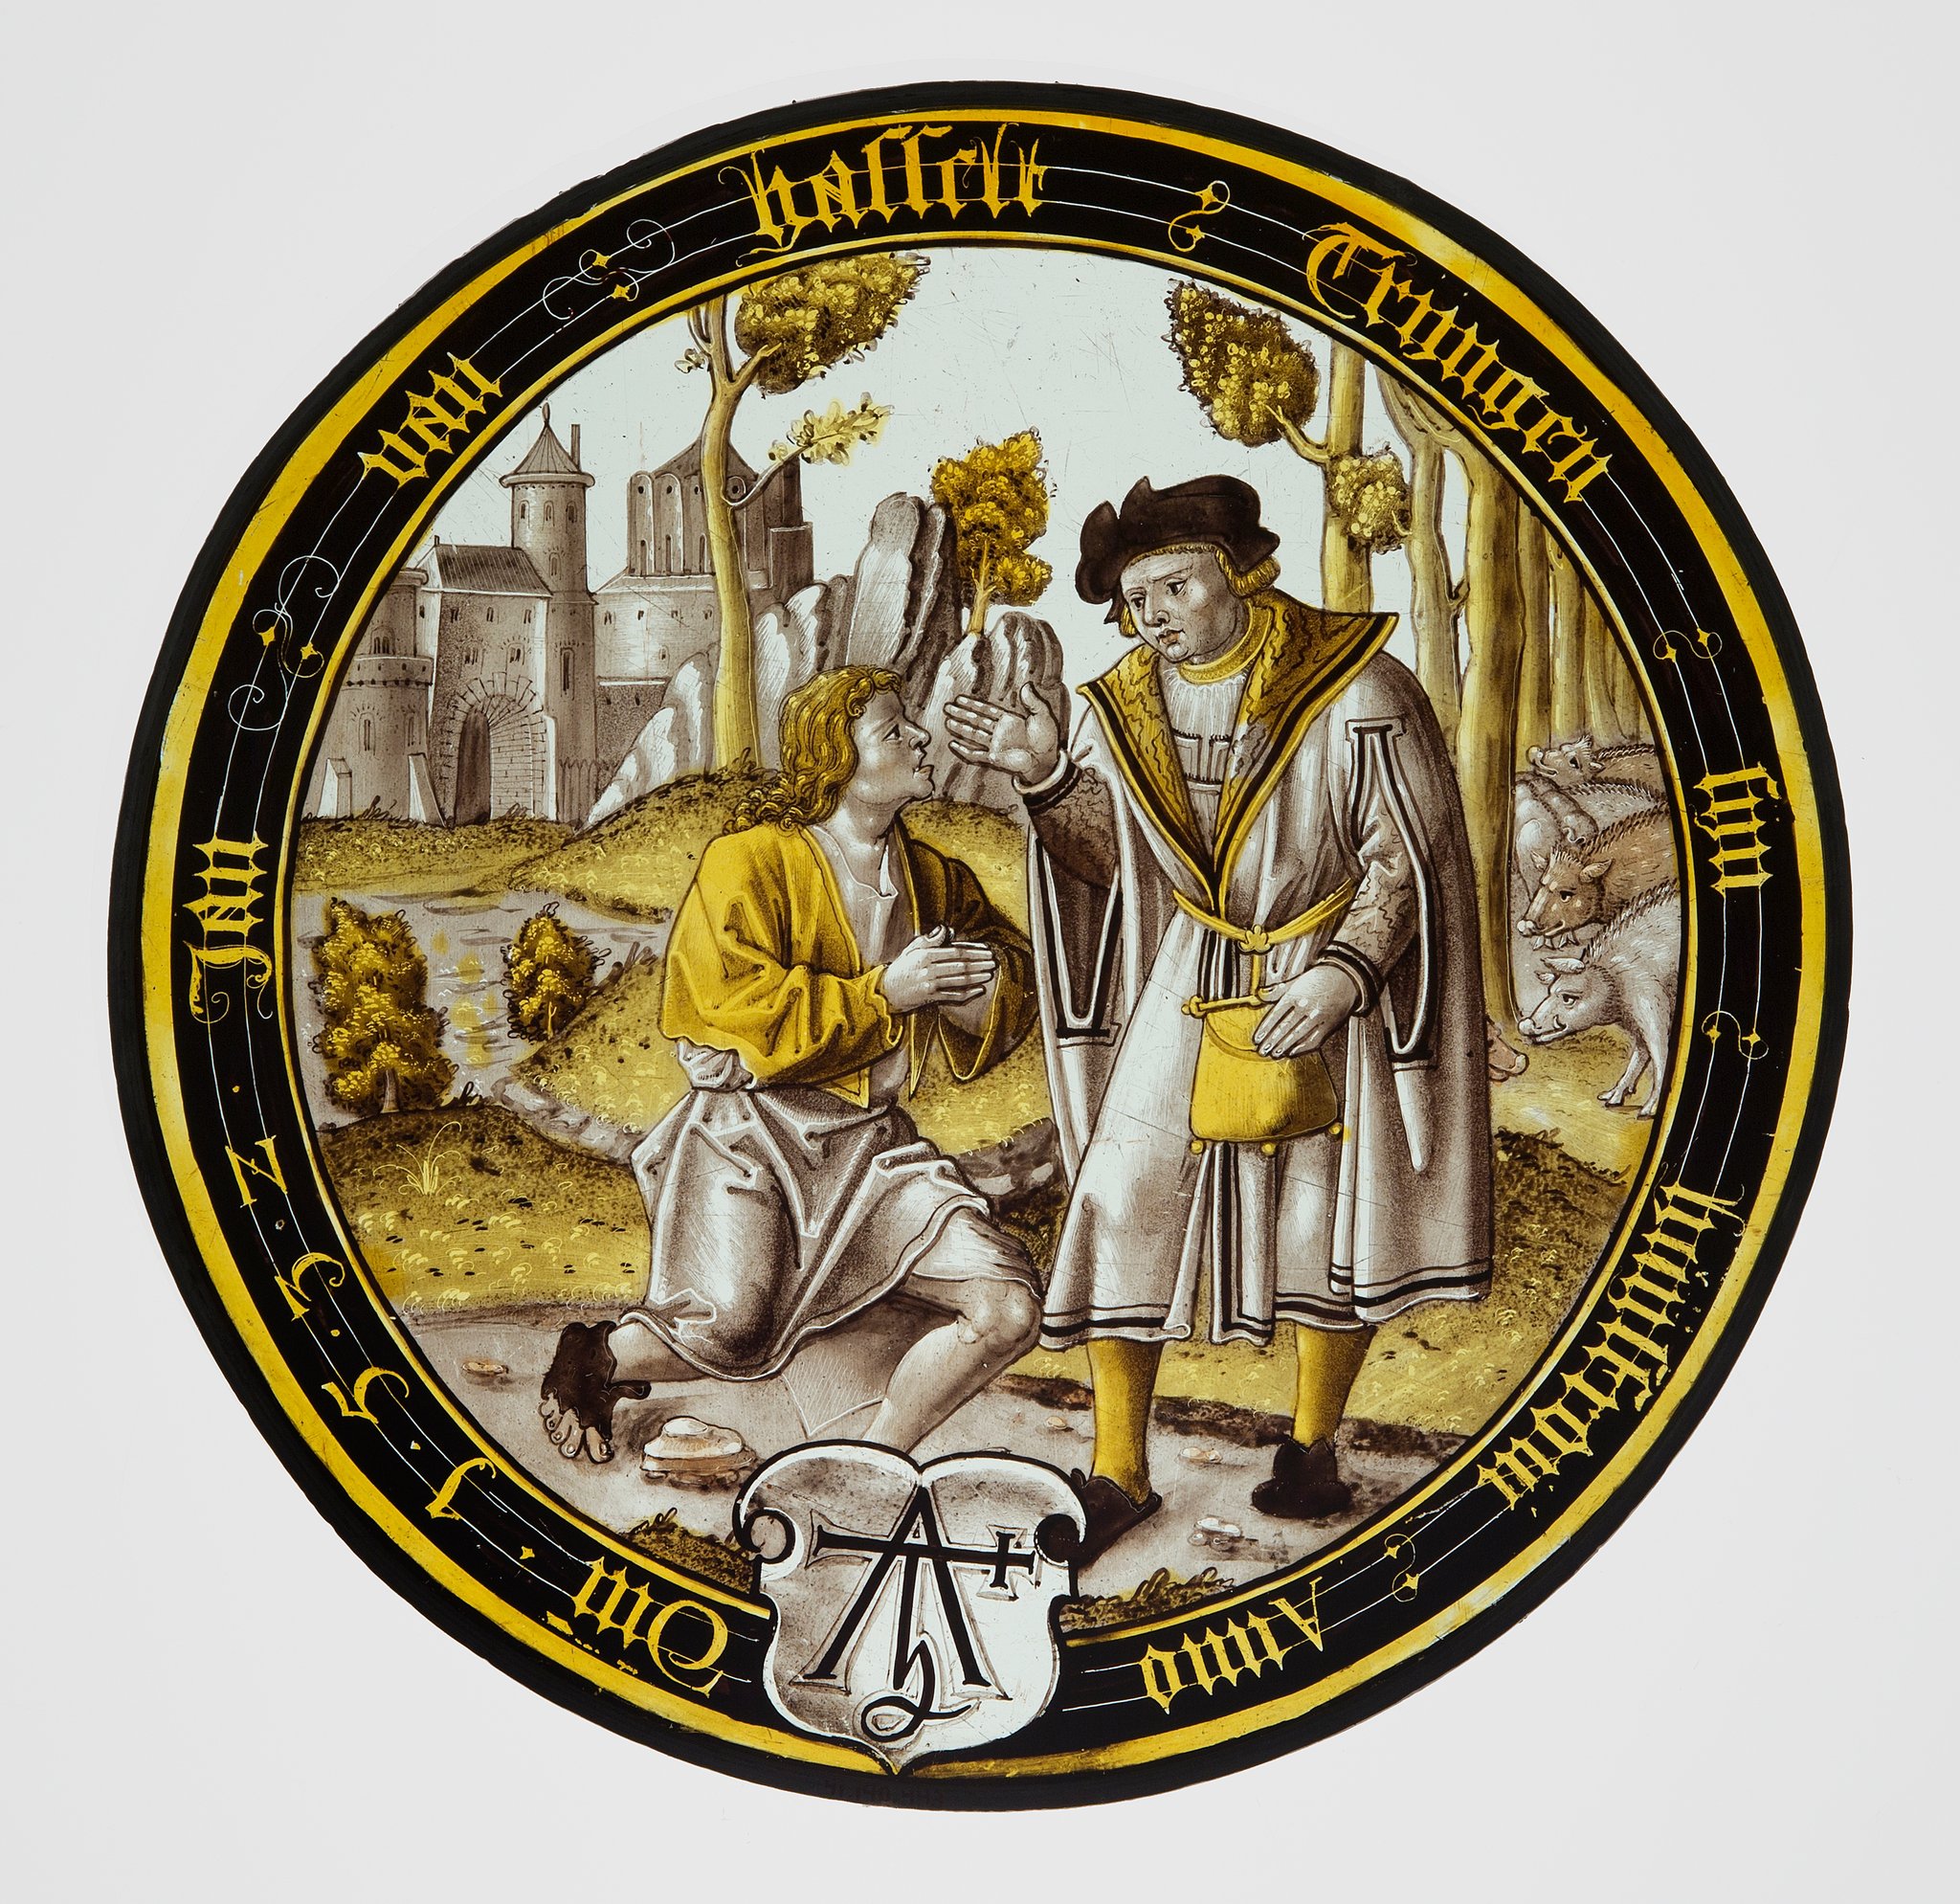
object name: roundel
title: The Prodigal Seeks Work (one of eight scenes from the story of the Prodigal Son)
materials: glass, paint, pigment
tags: castles,men,pigs